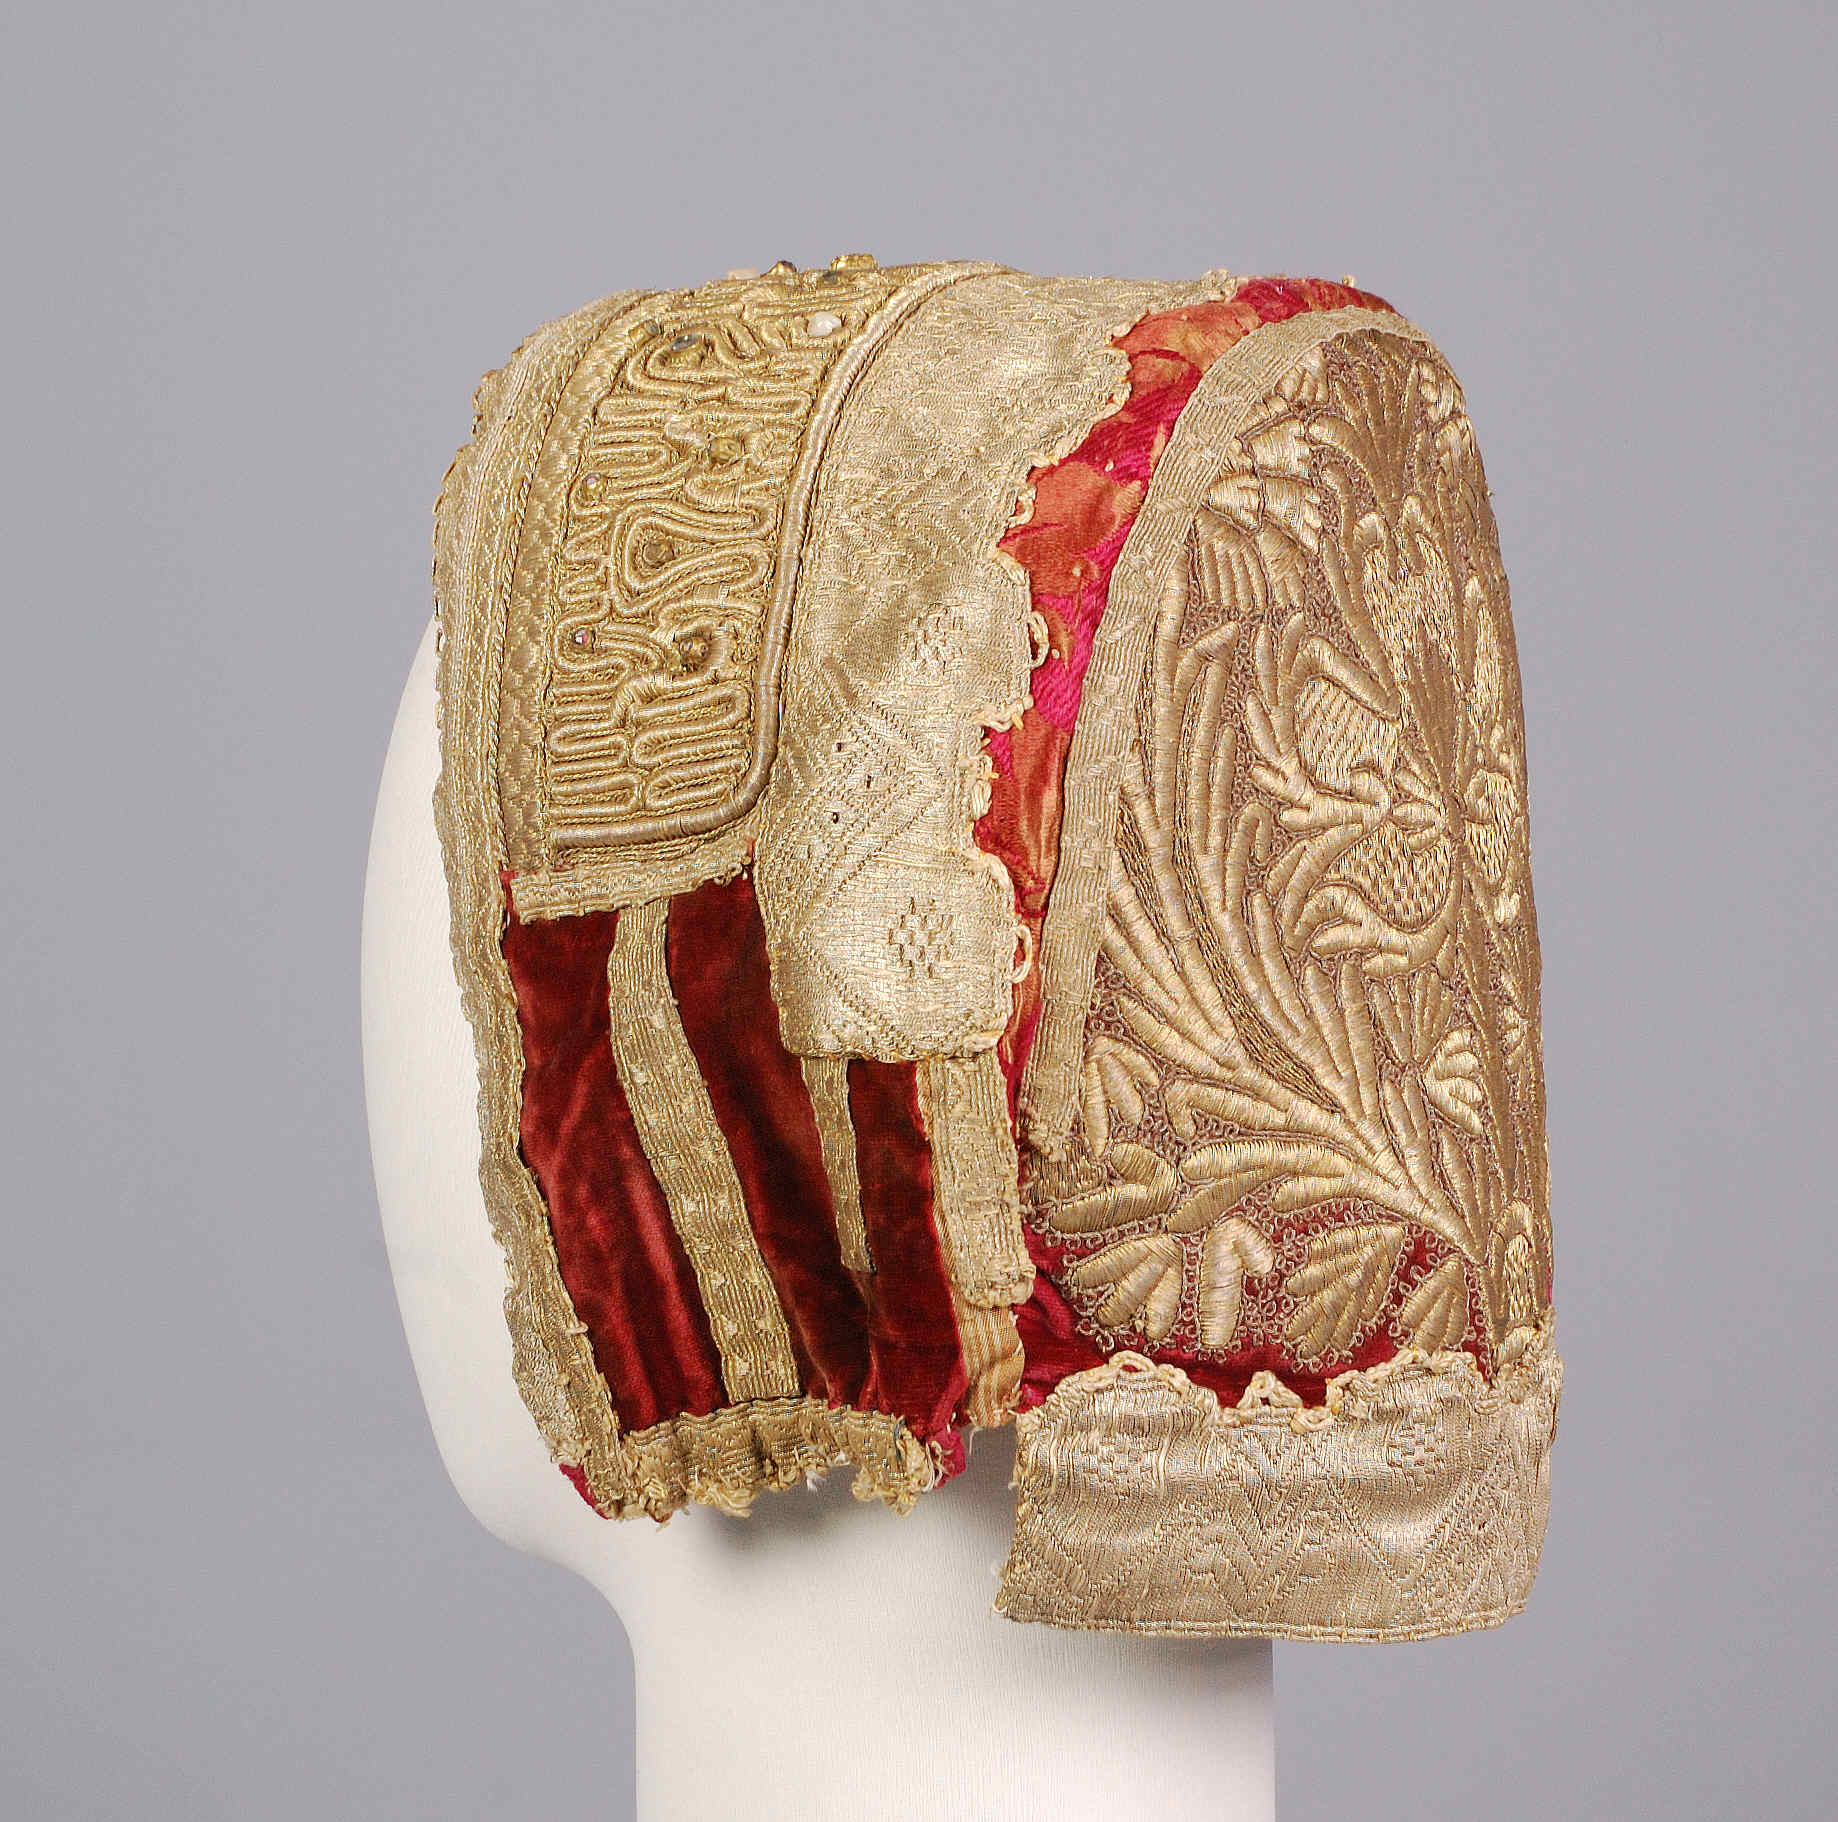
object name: hat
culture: russian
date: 1801-1900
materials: glass, pearl, silk